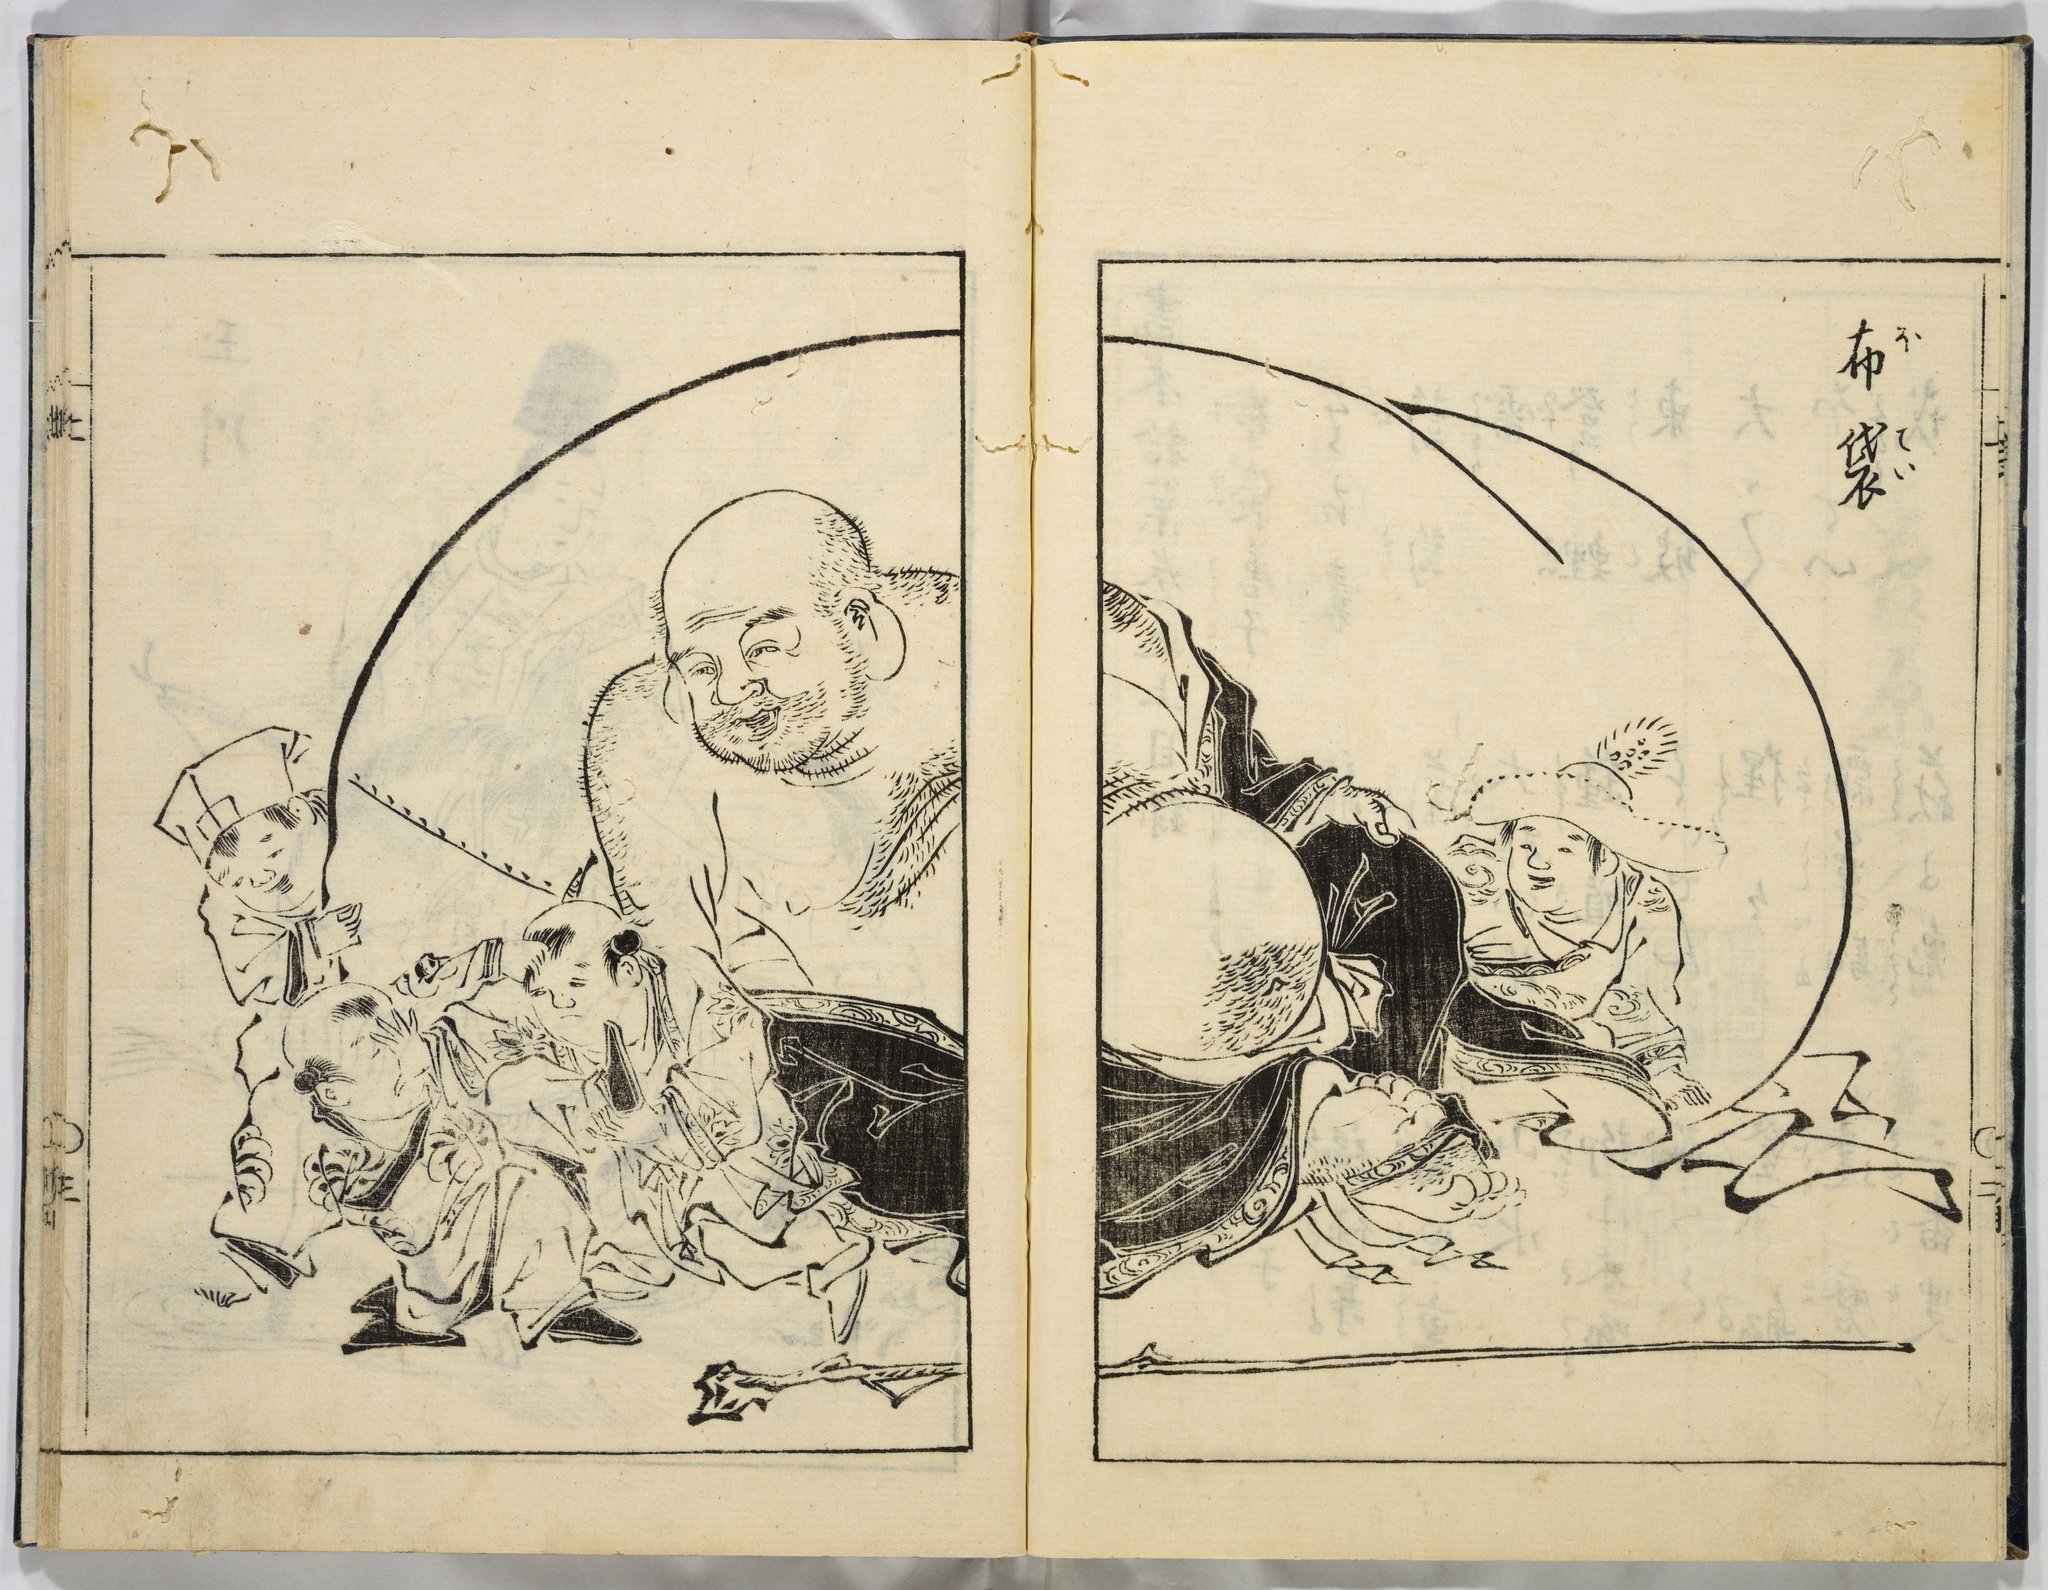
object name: illustrated book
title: A Collection of Sketches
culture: japanese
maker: sesshosai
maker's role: artist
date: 1751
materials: ink, paper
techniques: woodblock print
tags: boys,men